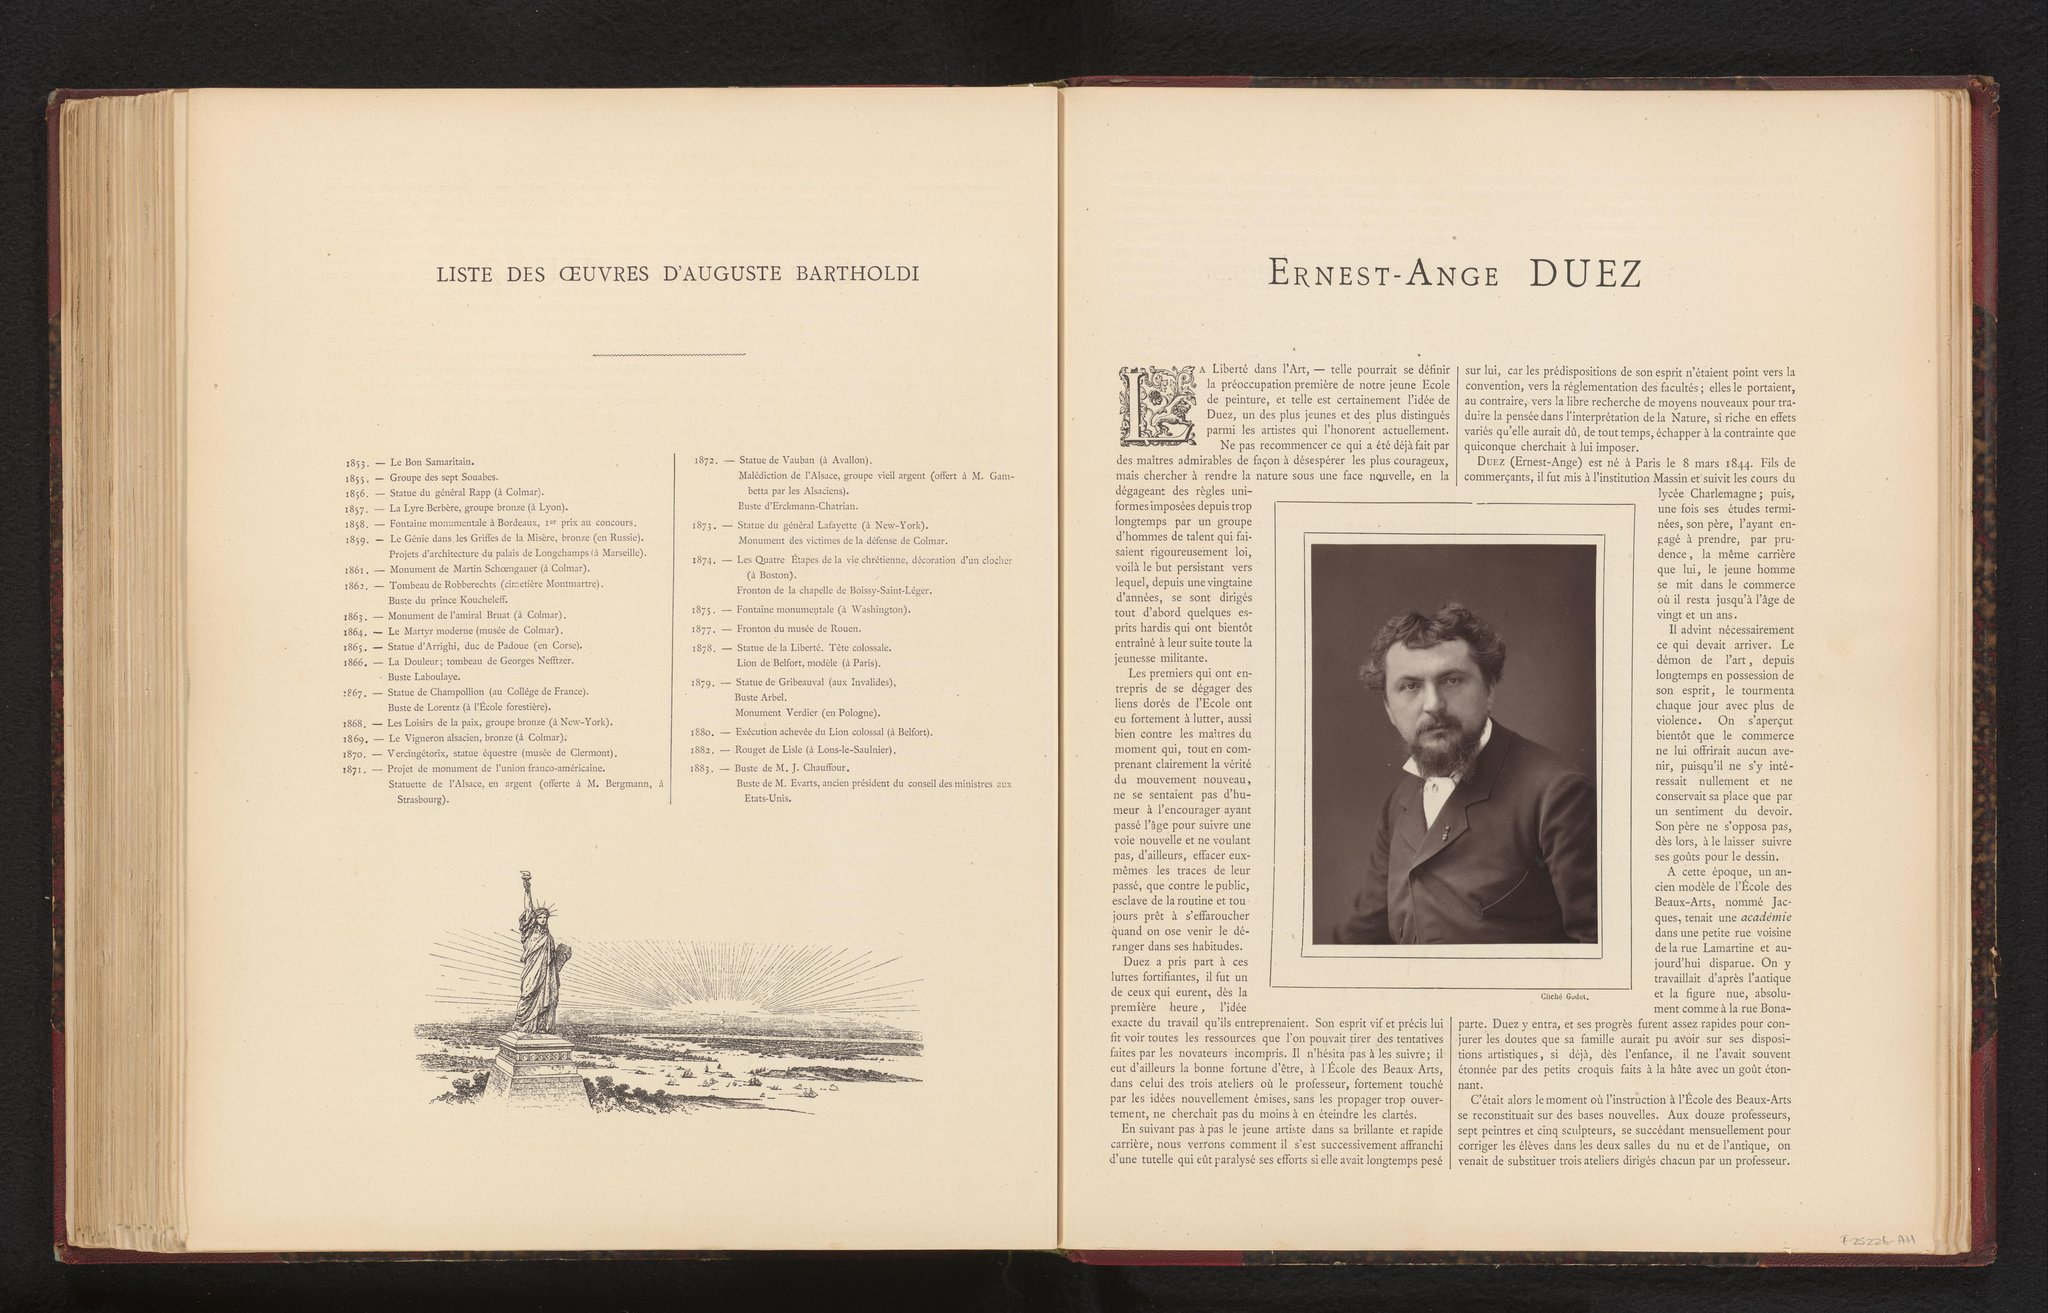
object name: photomechanical print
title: Portret van Ernest-Ange Duez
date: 1878-1883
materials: paper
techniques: woodburytype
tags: paris, painter, ernest-ange duez, historical persons